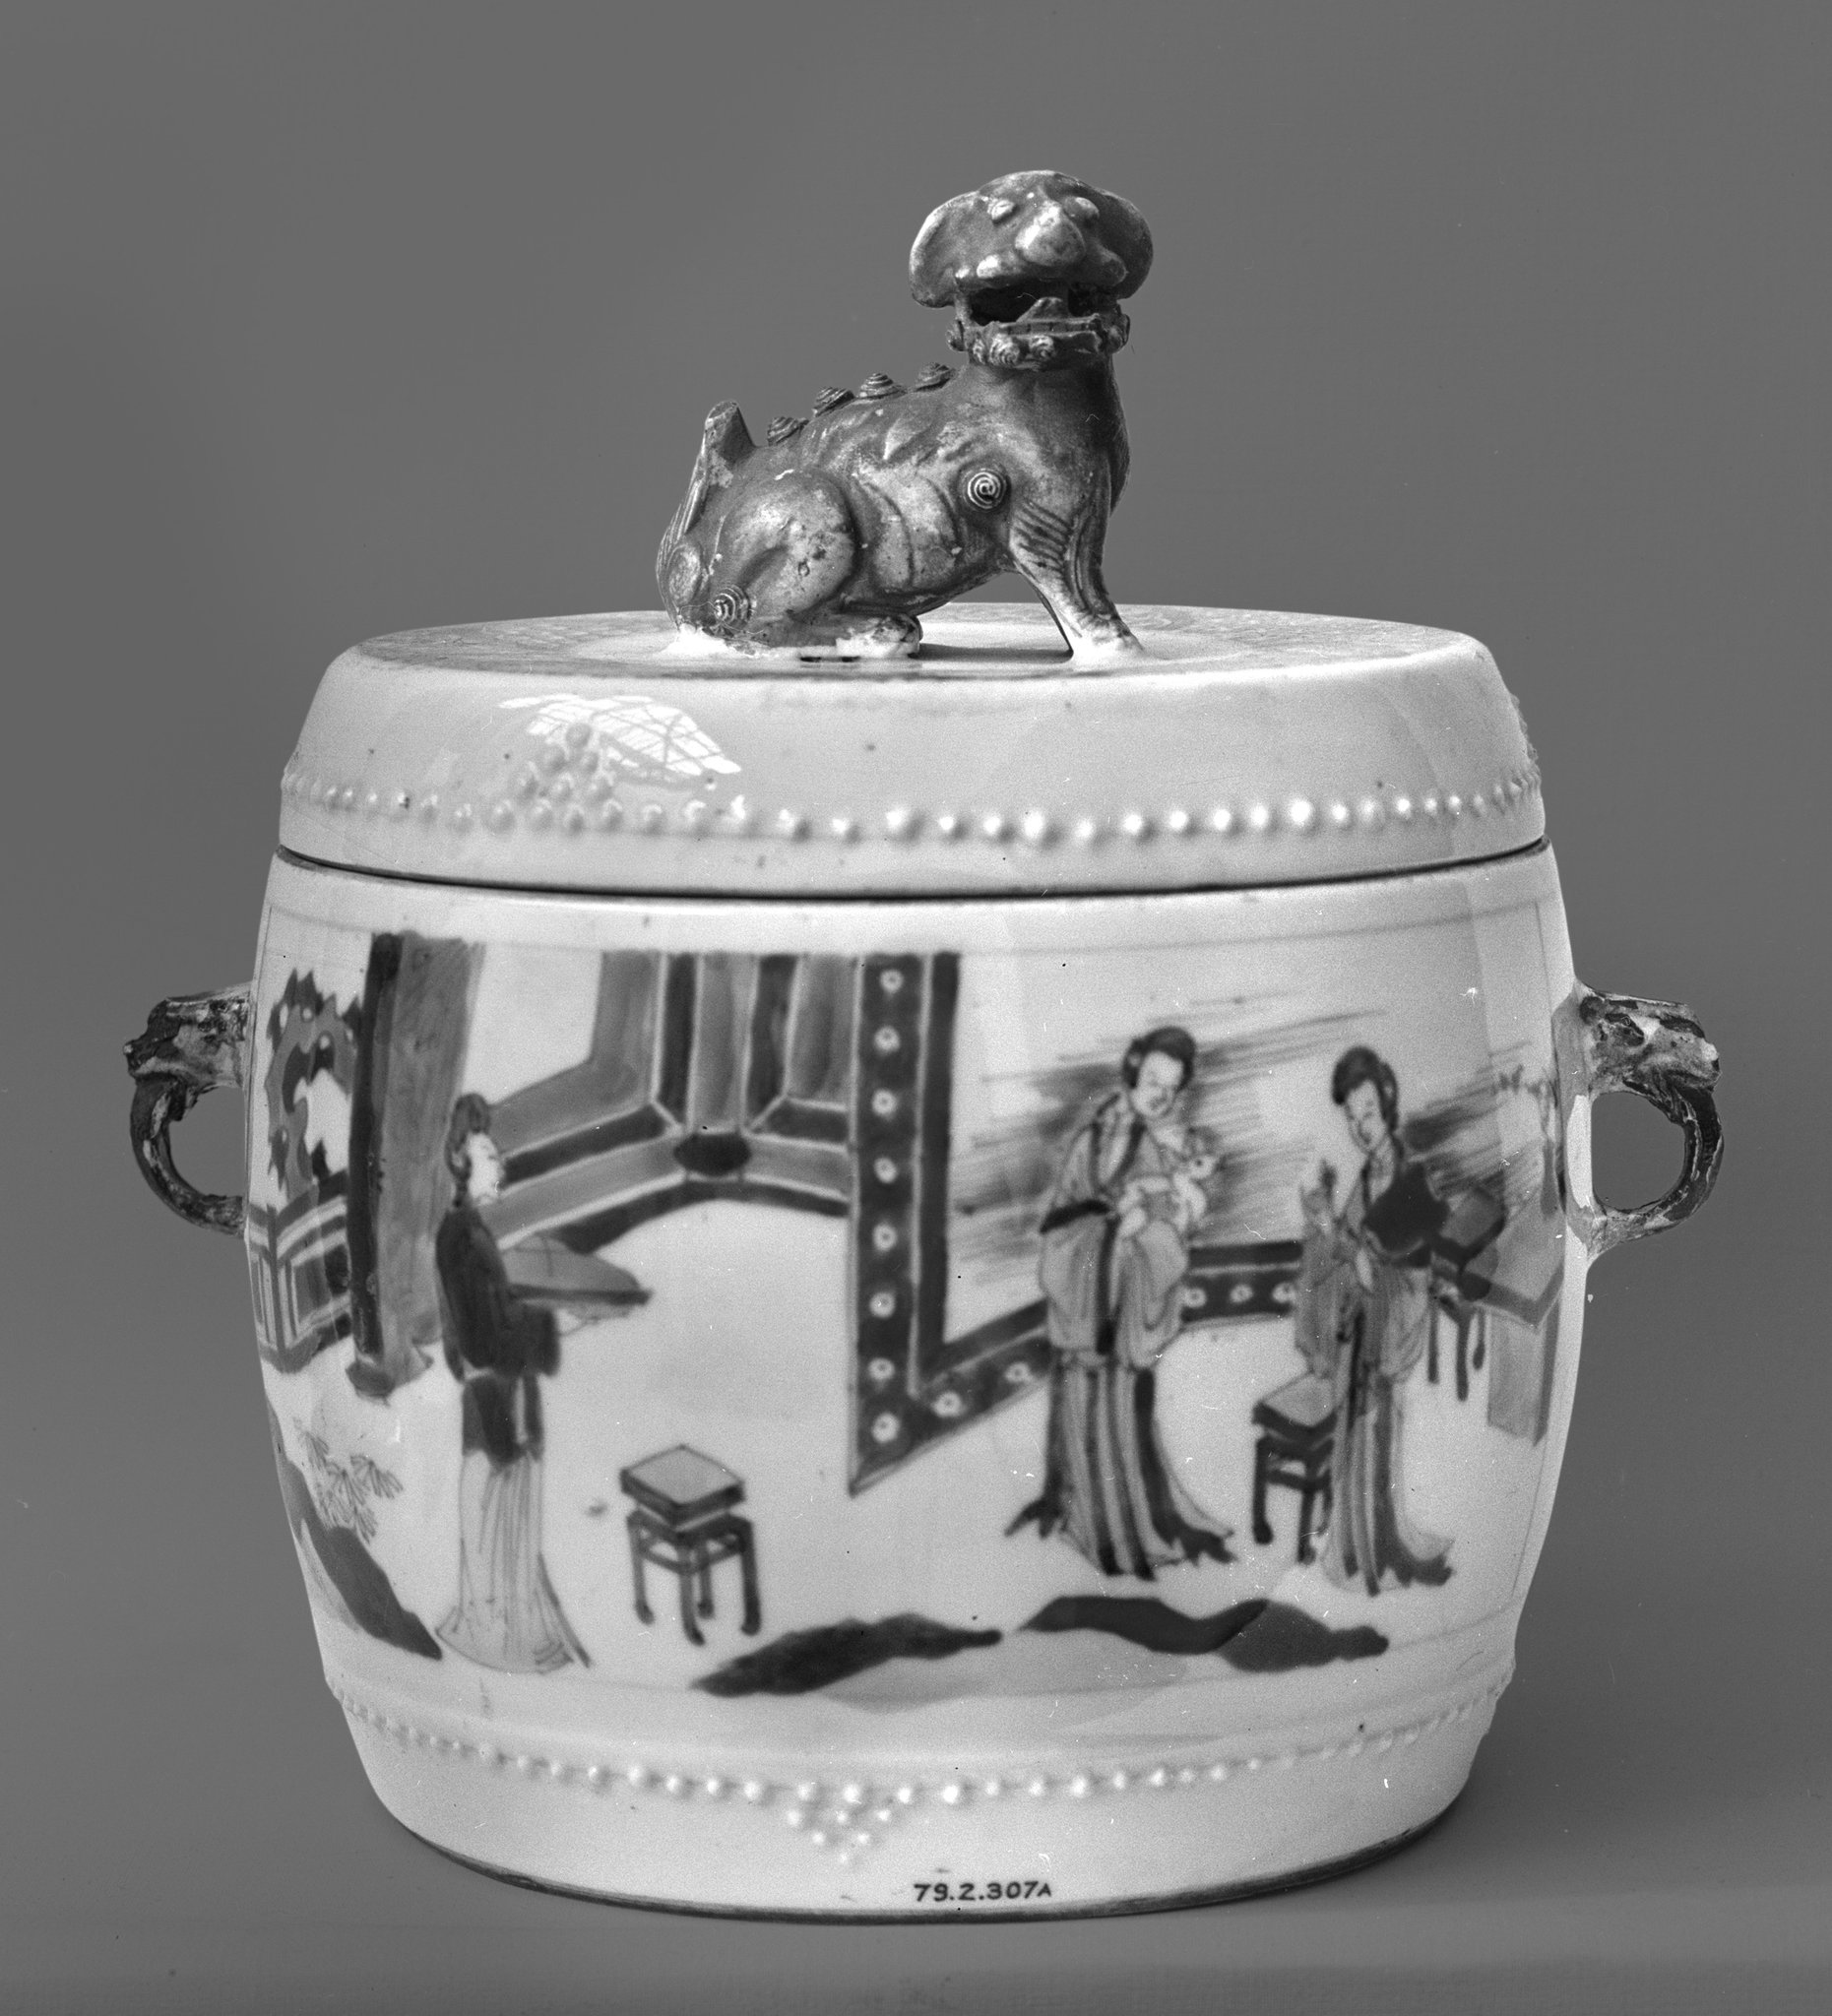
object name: covered tureen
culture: chinese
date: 1667-1733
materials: biscuit, porcelain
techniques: gilding, painting, underglaze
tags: women,dogs